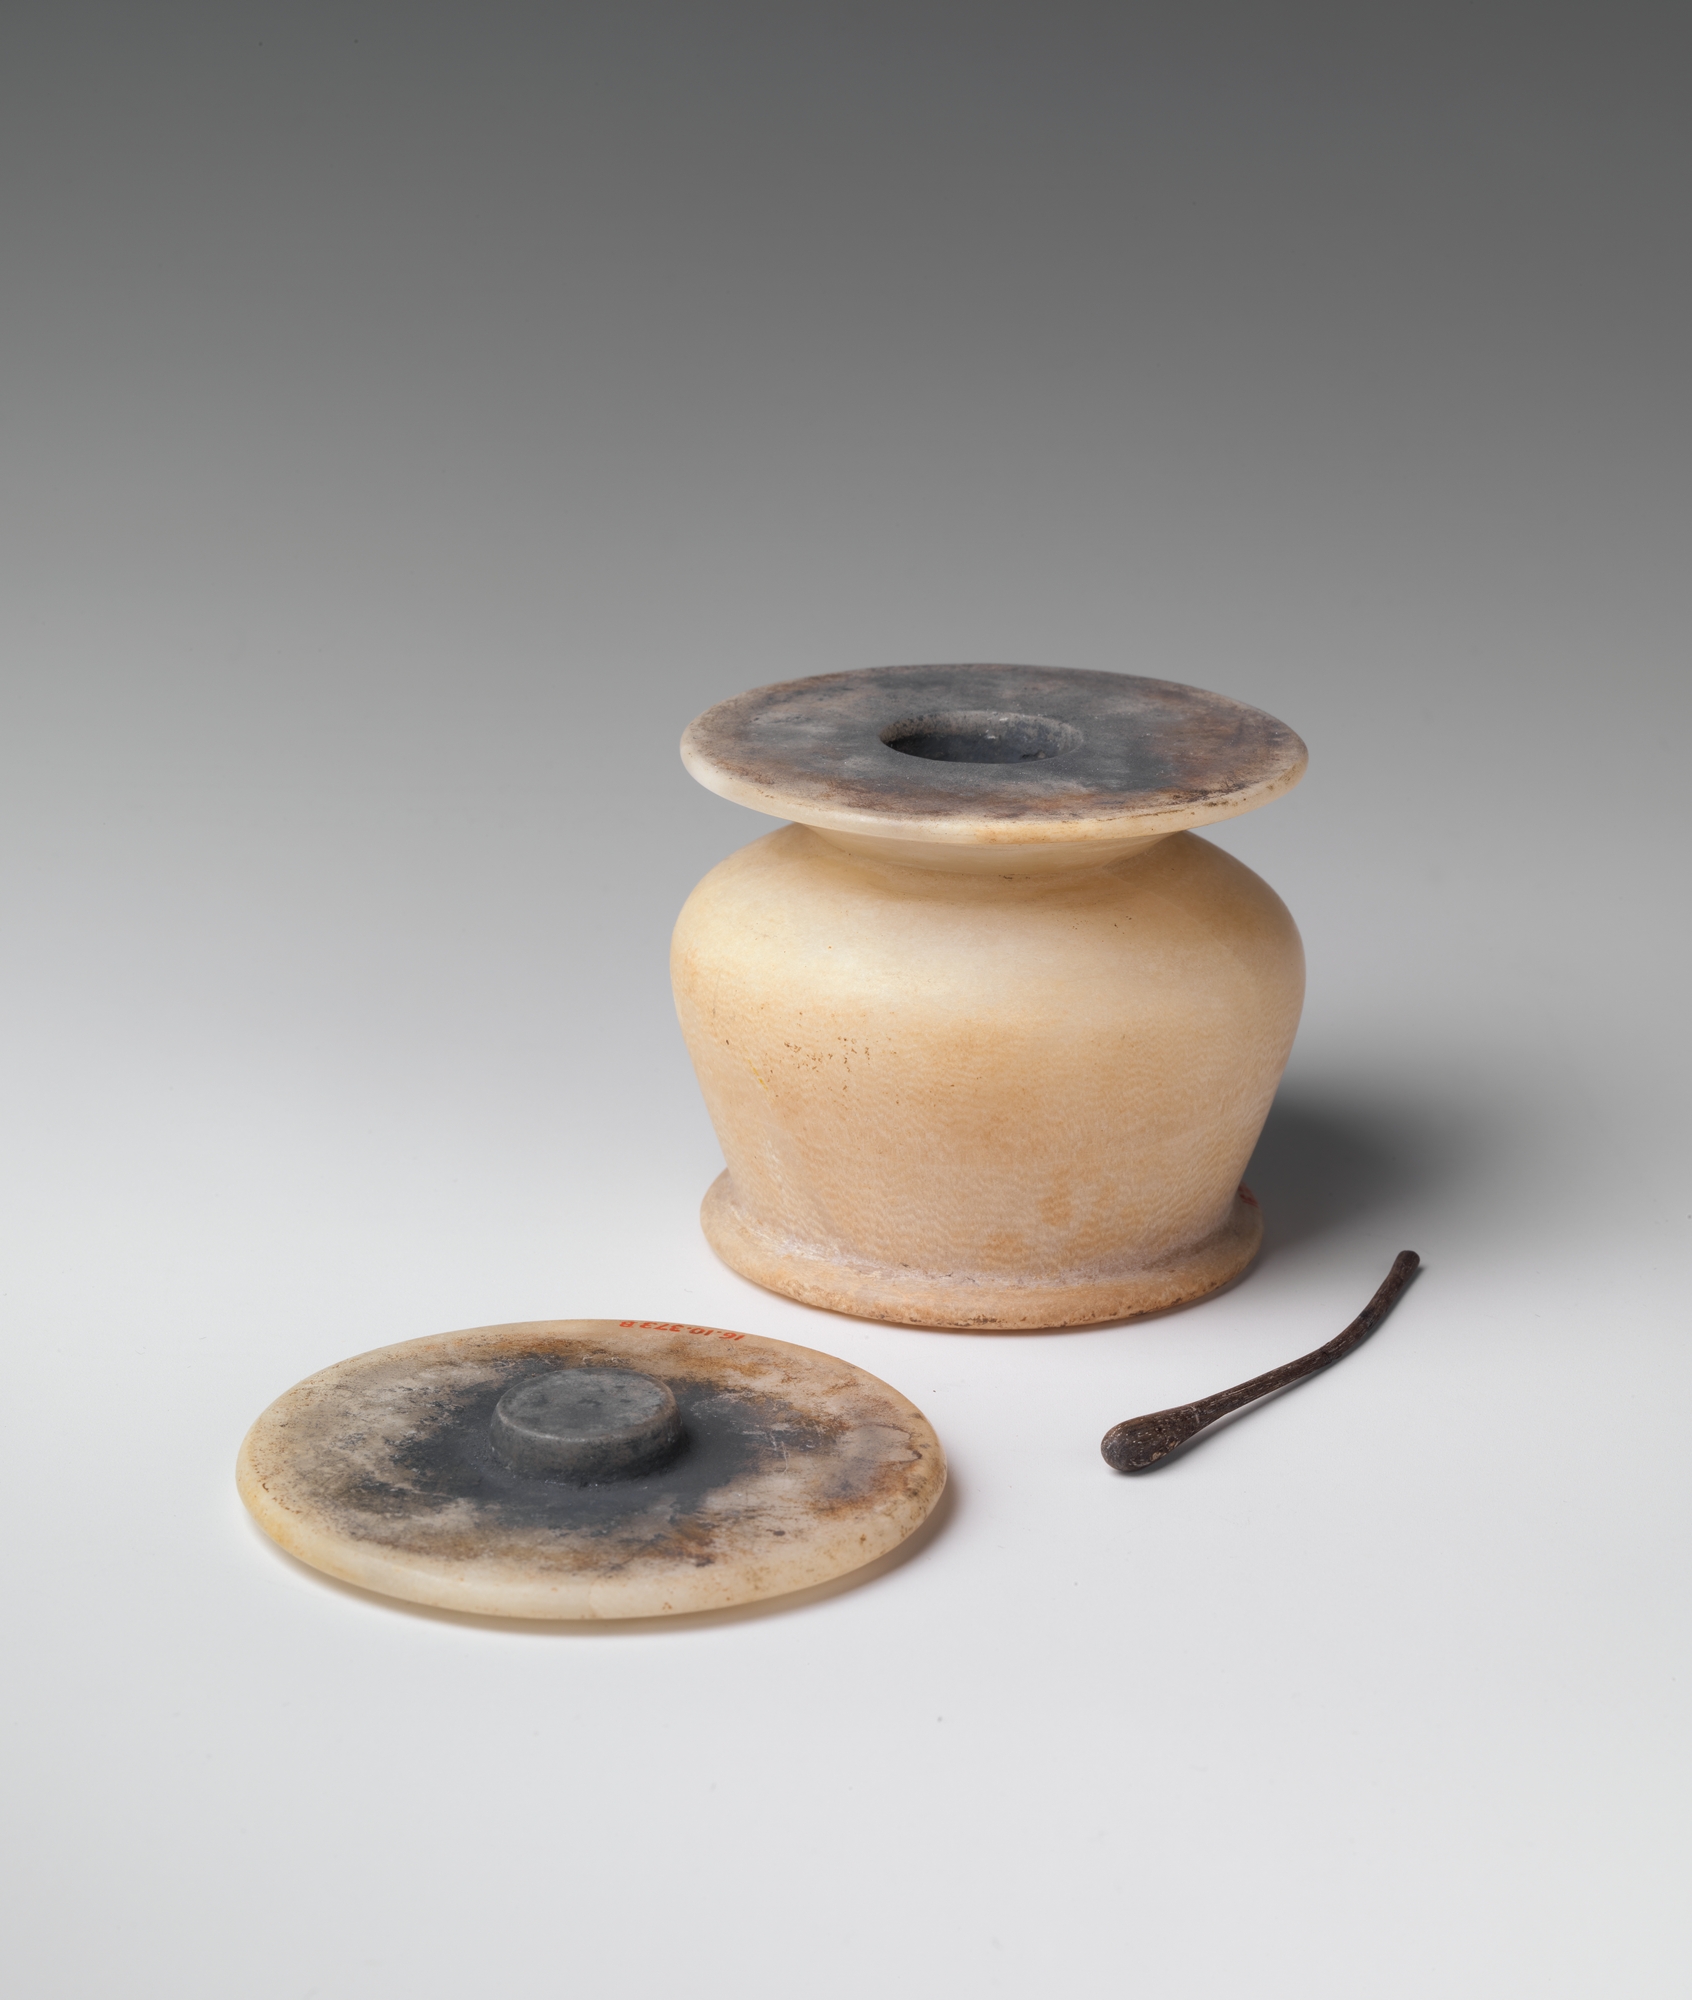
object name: kohl jar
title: Kohl Jar and Stick (with 16.10.373c)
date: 1635-1458 BCE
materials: stone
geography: egypt